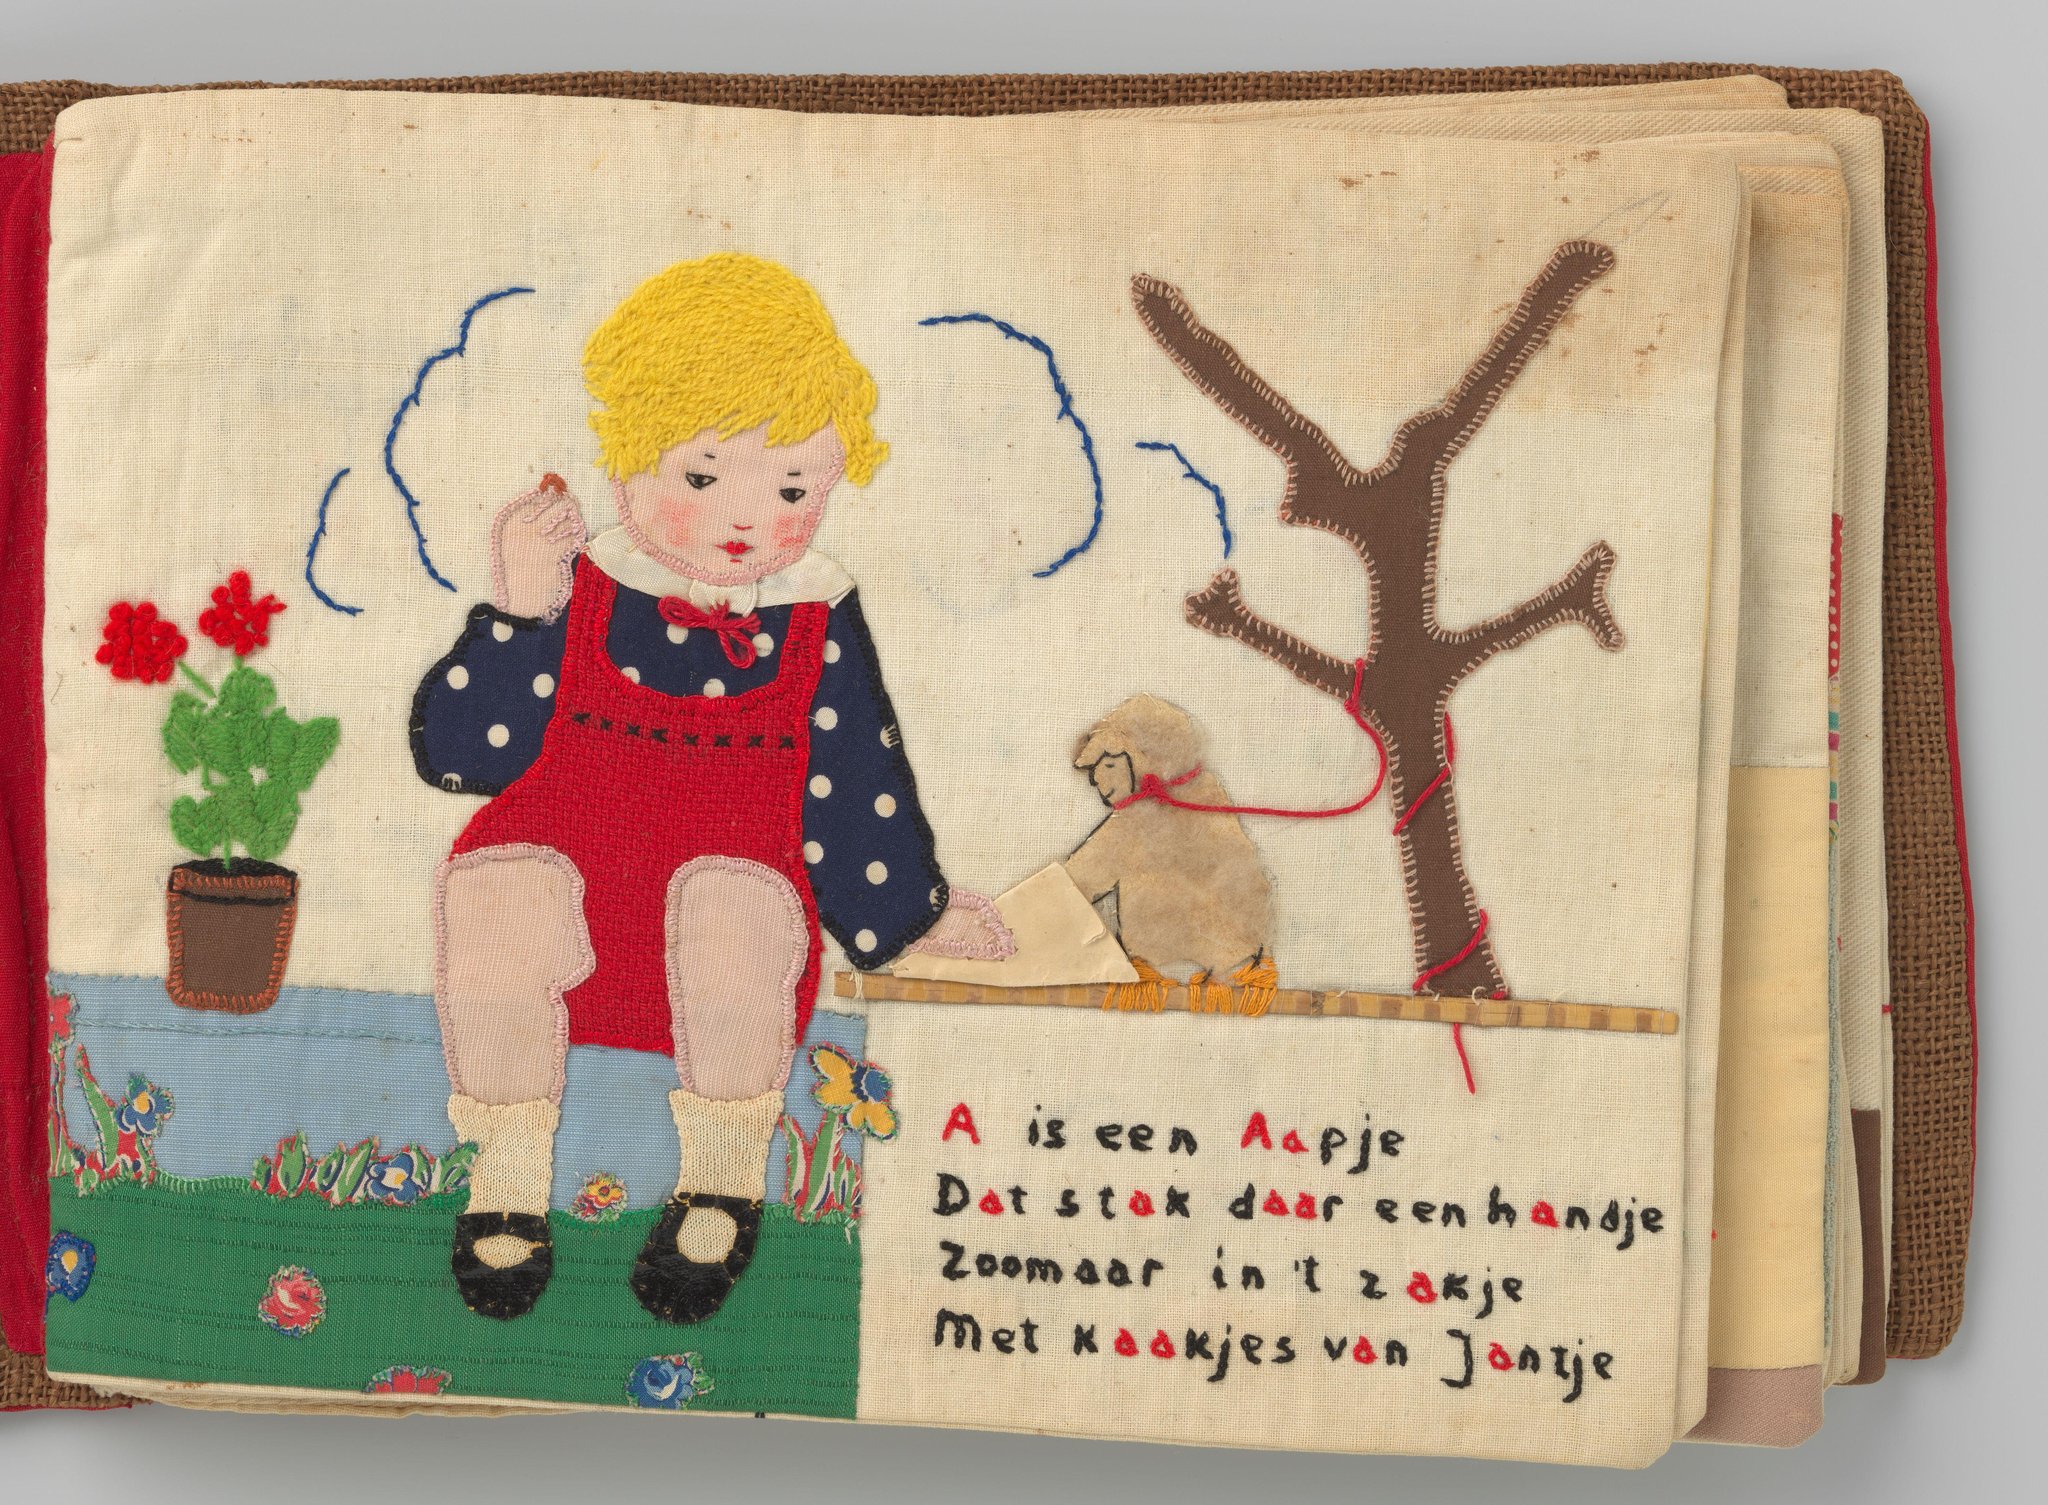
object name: blad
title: A is een Aapje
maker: miesje geertruida maria petronella aalbersberg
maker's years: 1915-1997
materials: cotton, textile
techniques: appliqué, embroidered, stitch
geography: brastagi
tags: reading, book in which illustrations are essential, letters, alphabet, script, internment camp, nursery school (+ teaching aids), (other forms of) needlework, e.g.: crocheting, knitting, embroidering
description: Illegaal kinderboek in textiel vrij naar A is een Aapje van Rie Cramer, gezamenlijk gemaakt door de vrouwelijke gevangenen van het Japanse interneringskamp Brastagi, een oude plantage in Noord-Sumatra 60 kilometer ten zuiden van Medan aan de weg naar het Toba-meer, tijdens de Tweede Wereldoorlog ter gelegenheid van de vijfde verjaardag van Pem Hagers, de dochter van Miesje Hagers-Aalbersberg die de ontwerptekeningen en sjablonen had gemaakt.